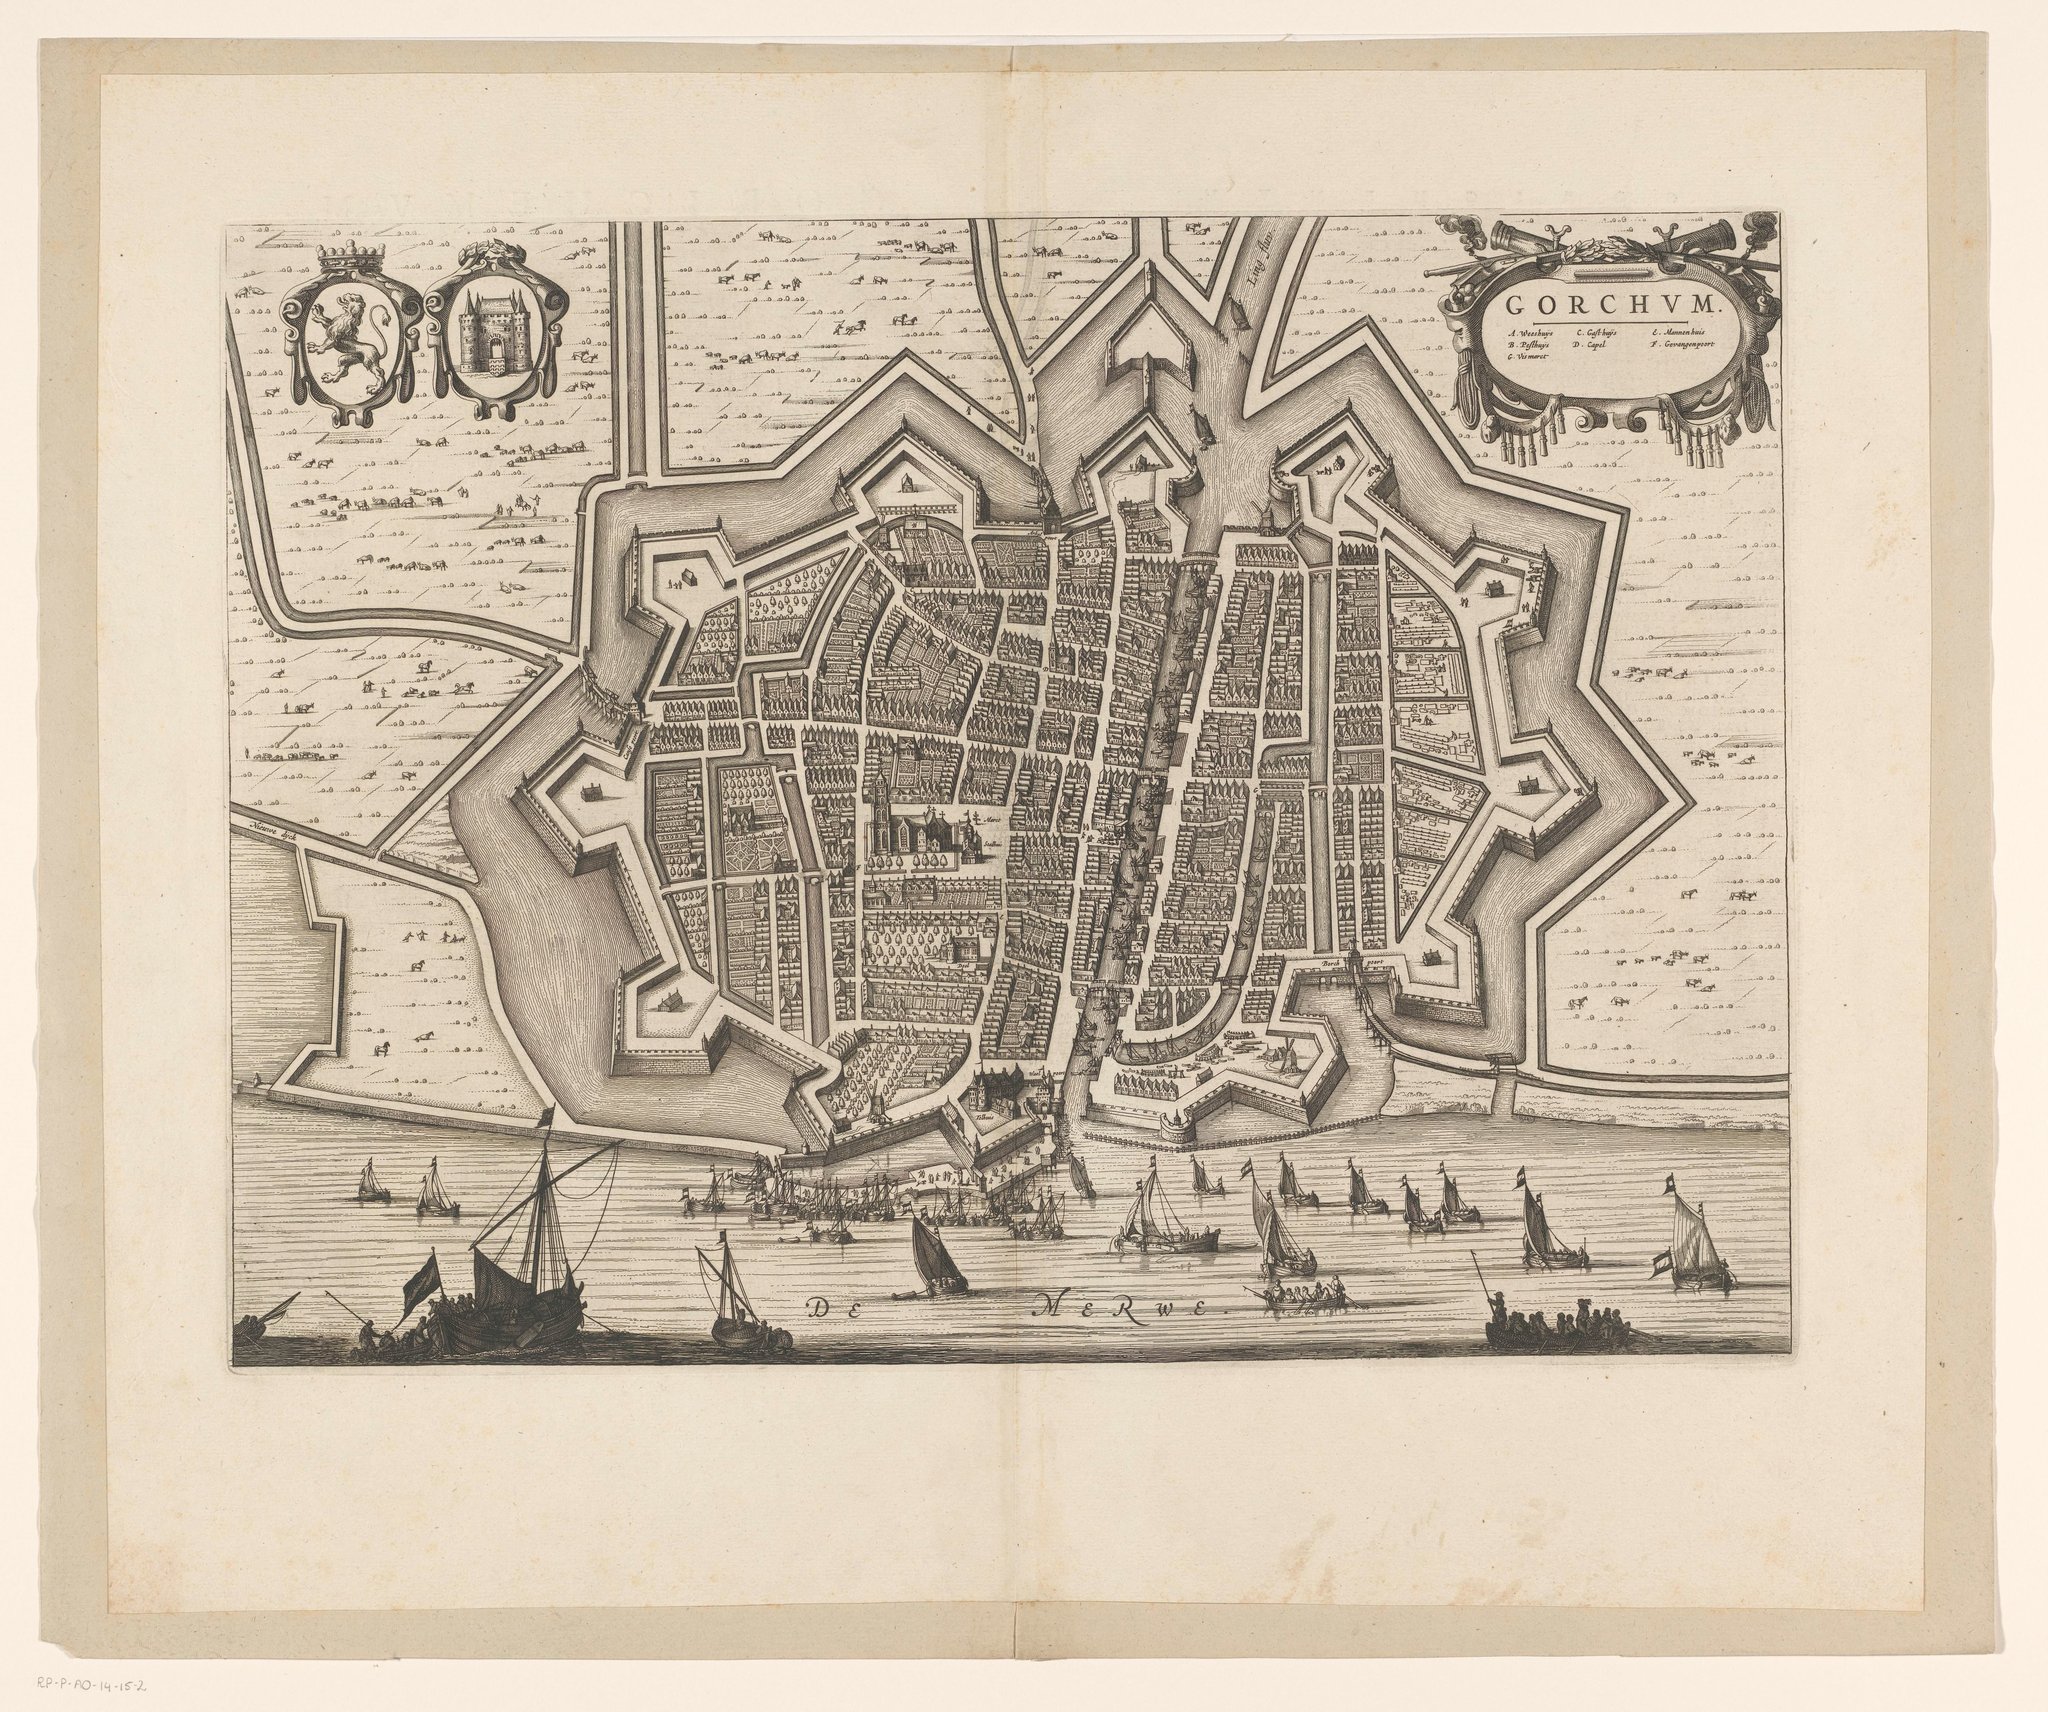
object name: area plan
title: Gorchum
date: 1652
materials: paper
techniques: engraving, etching, letterpress printing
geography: amsterdam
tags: coat of arms (as symbol of the state, etc.) (+ city; municipal), maps of cities, coat of arms (as symbol of the state, etc.) (+ province; provincial)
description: Plattegrond in vogelvluchtperspectief. Linksboven het wapen van Holland en dat van Gorinchem. Rechtsboven een cartouche met de titel en de legenda A-F. Op verso Latijnse tekst.